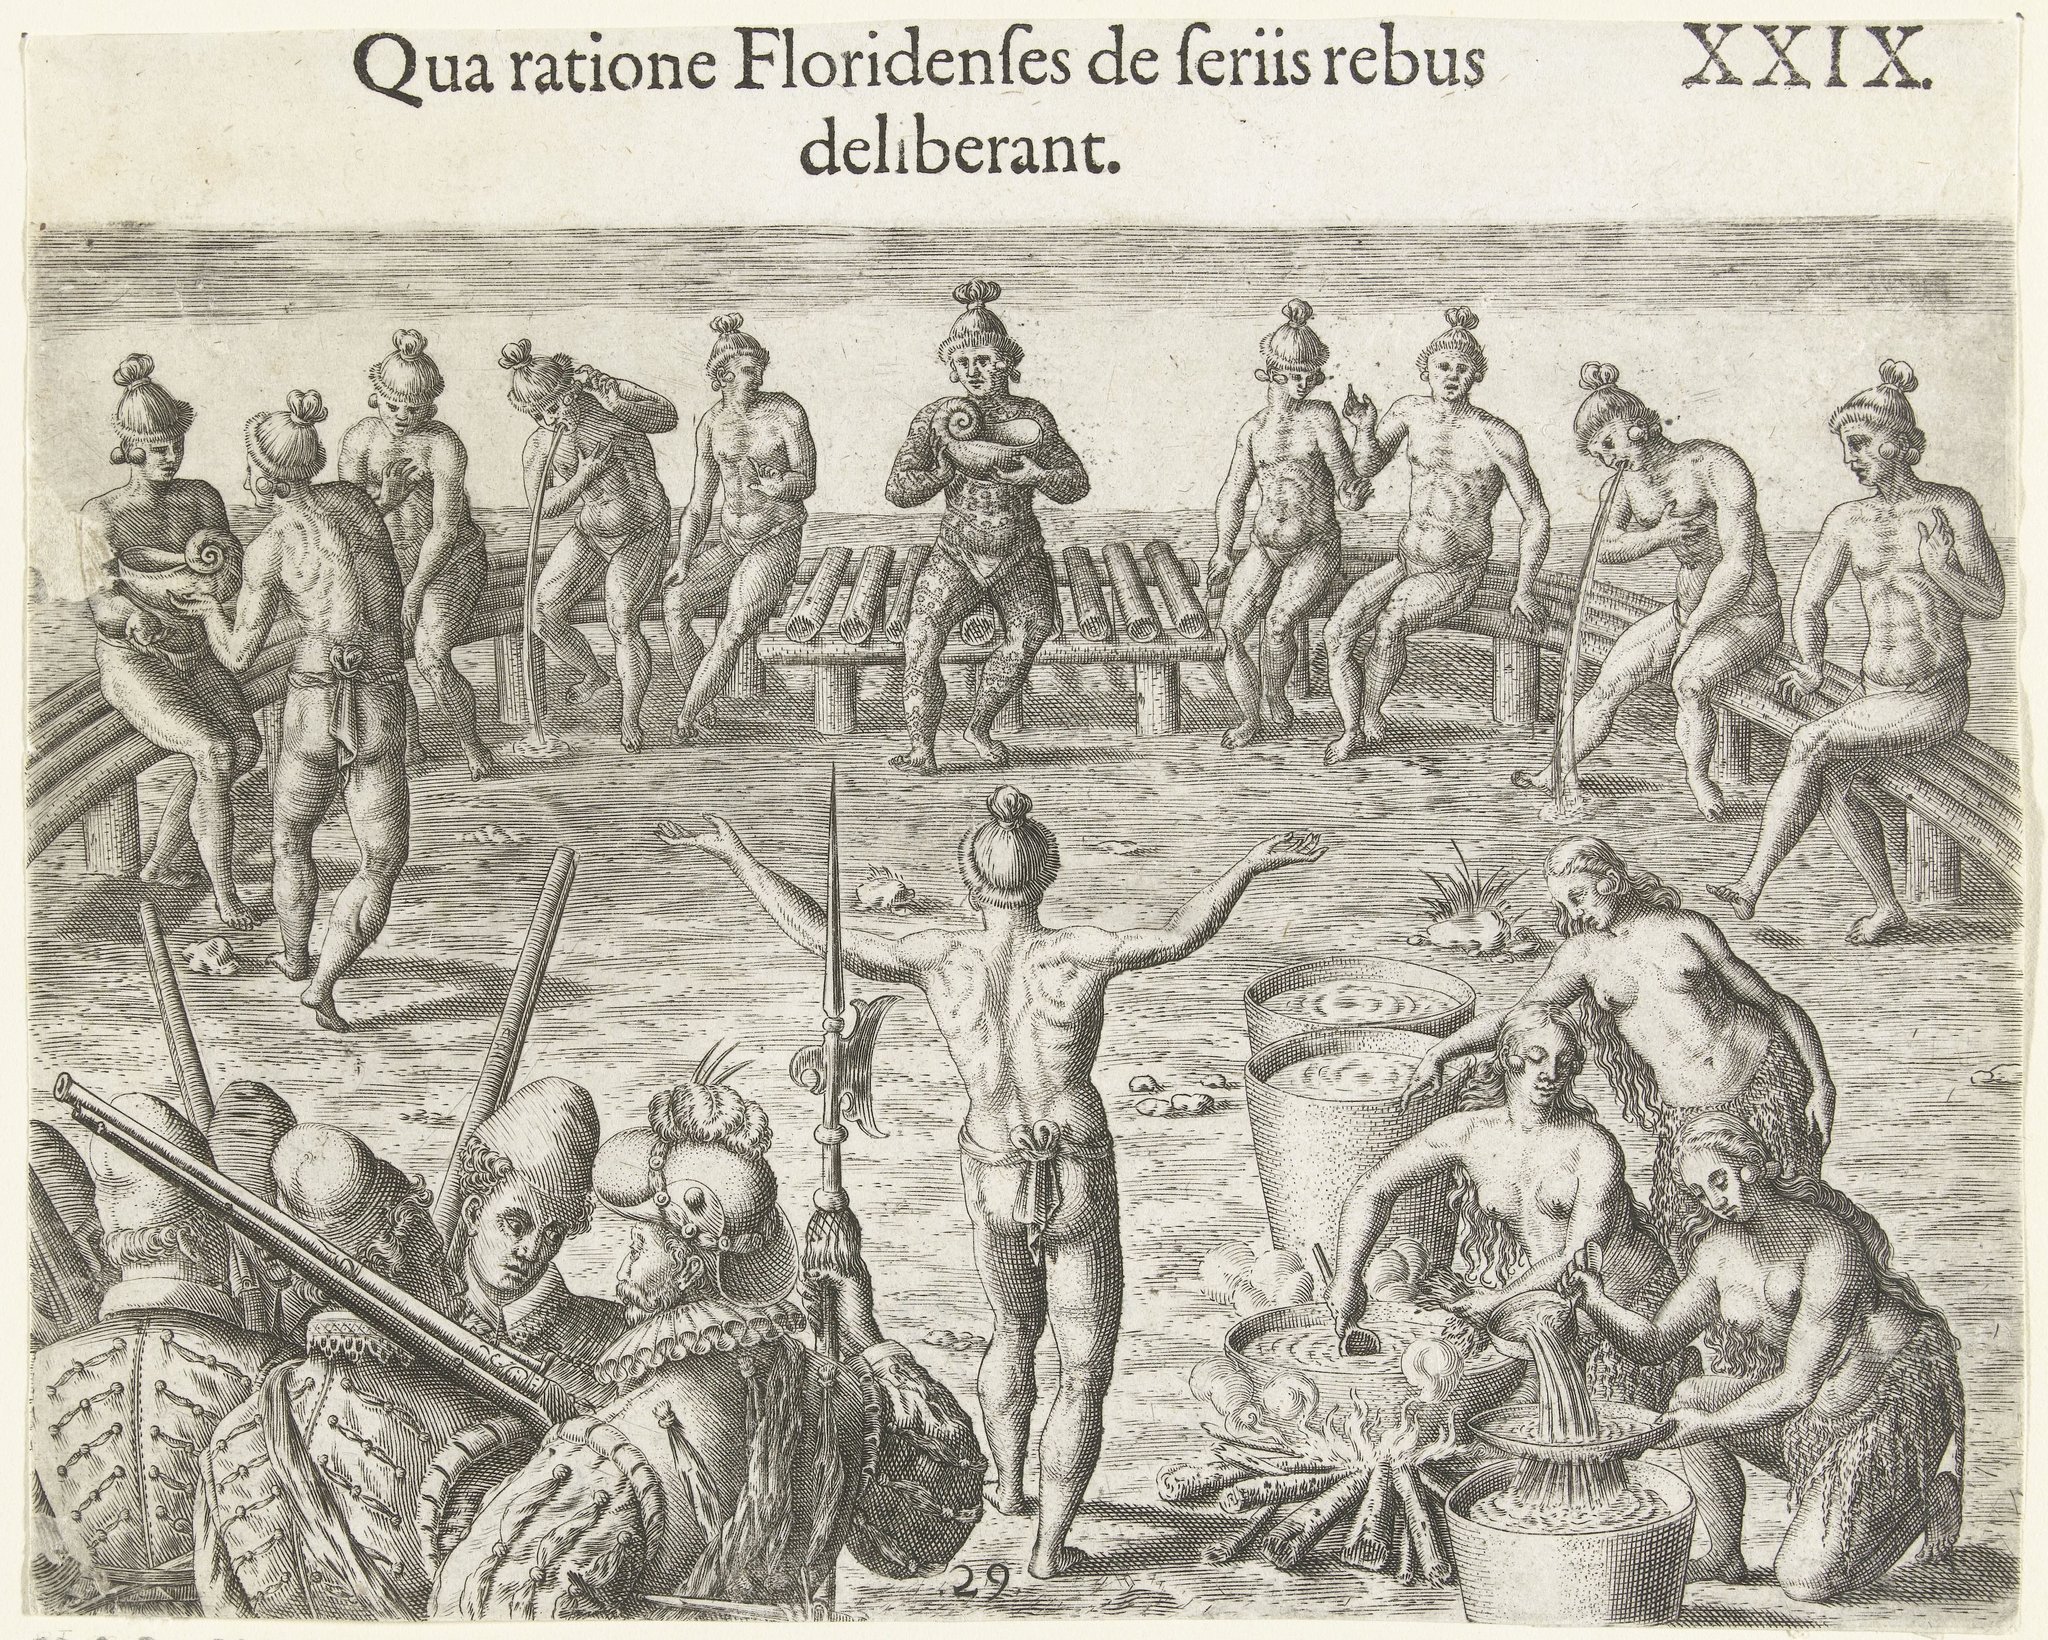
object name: print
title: India occidentalis II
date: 1591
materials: paper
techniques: engraving, letterpress printing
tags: vomiting, (family) meal - cc - out of doors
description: Het eten dat in grote pannen warm gehouden wordt op het vuur wordt uitgedeeld en in schelpen geserveerd. Een man deelt de schelpen uit aan een groep mannen die op een halfronde bank zit. schijnbaar is het eten niet lekker want twee mannen spugen op de grond.